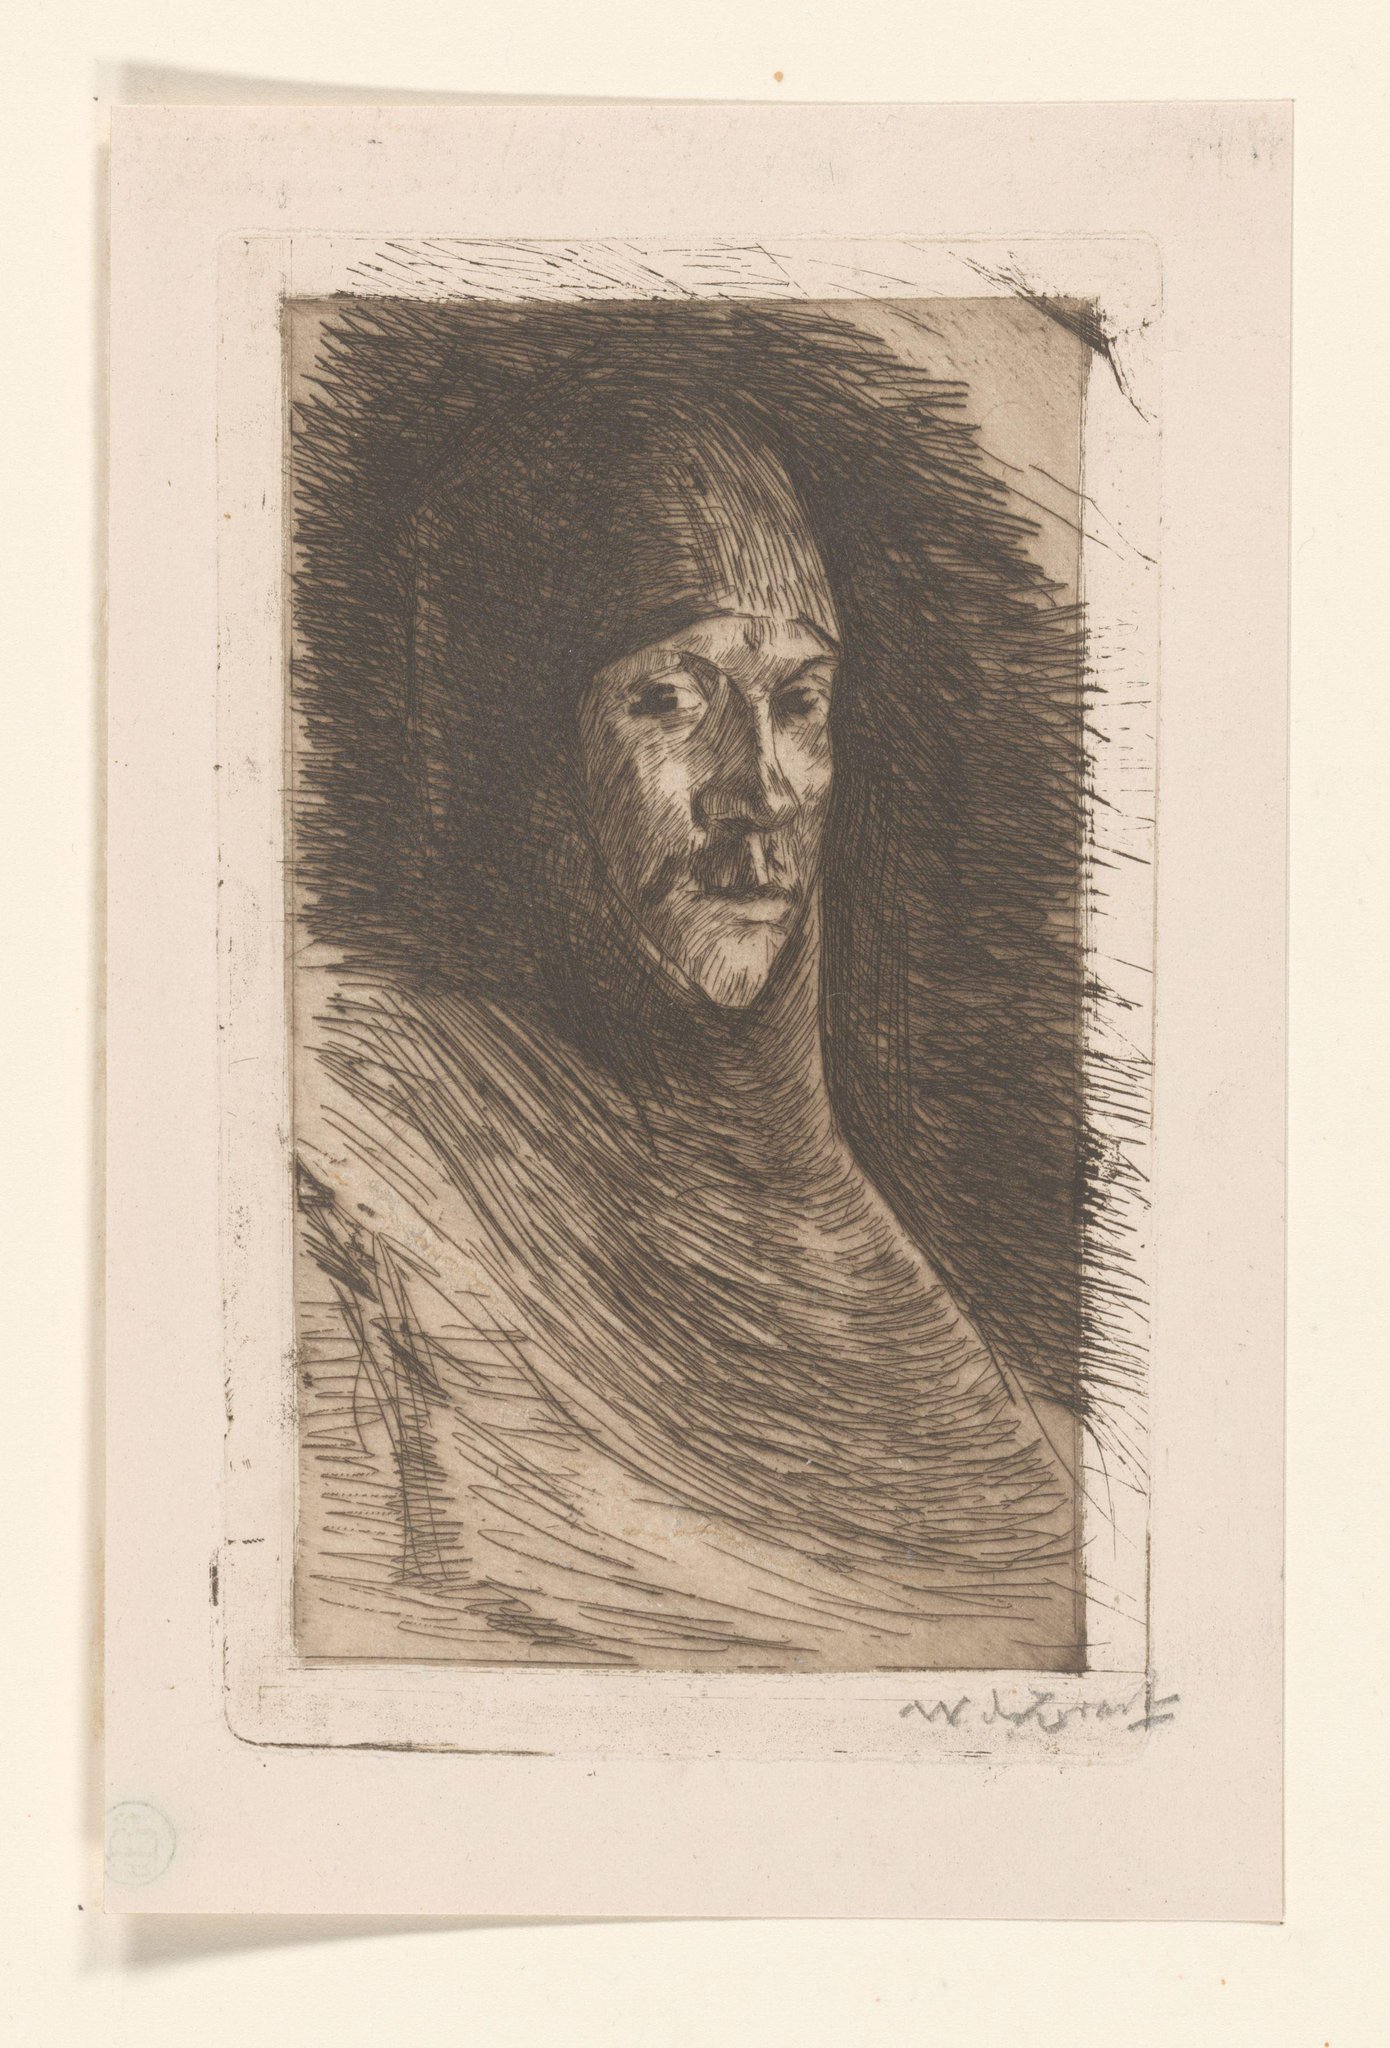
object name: print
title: Man met maliënkolder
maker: willem de zwart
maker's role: draughtsman, painter, print maker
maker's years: 1862-1931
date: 1884-1885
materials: paper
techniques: etching, intaglio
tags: historical persons, knight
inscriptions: collector's mark: Lugt 2228, collector's mark: Lugt 733